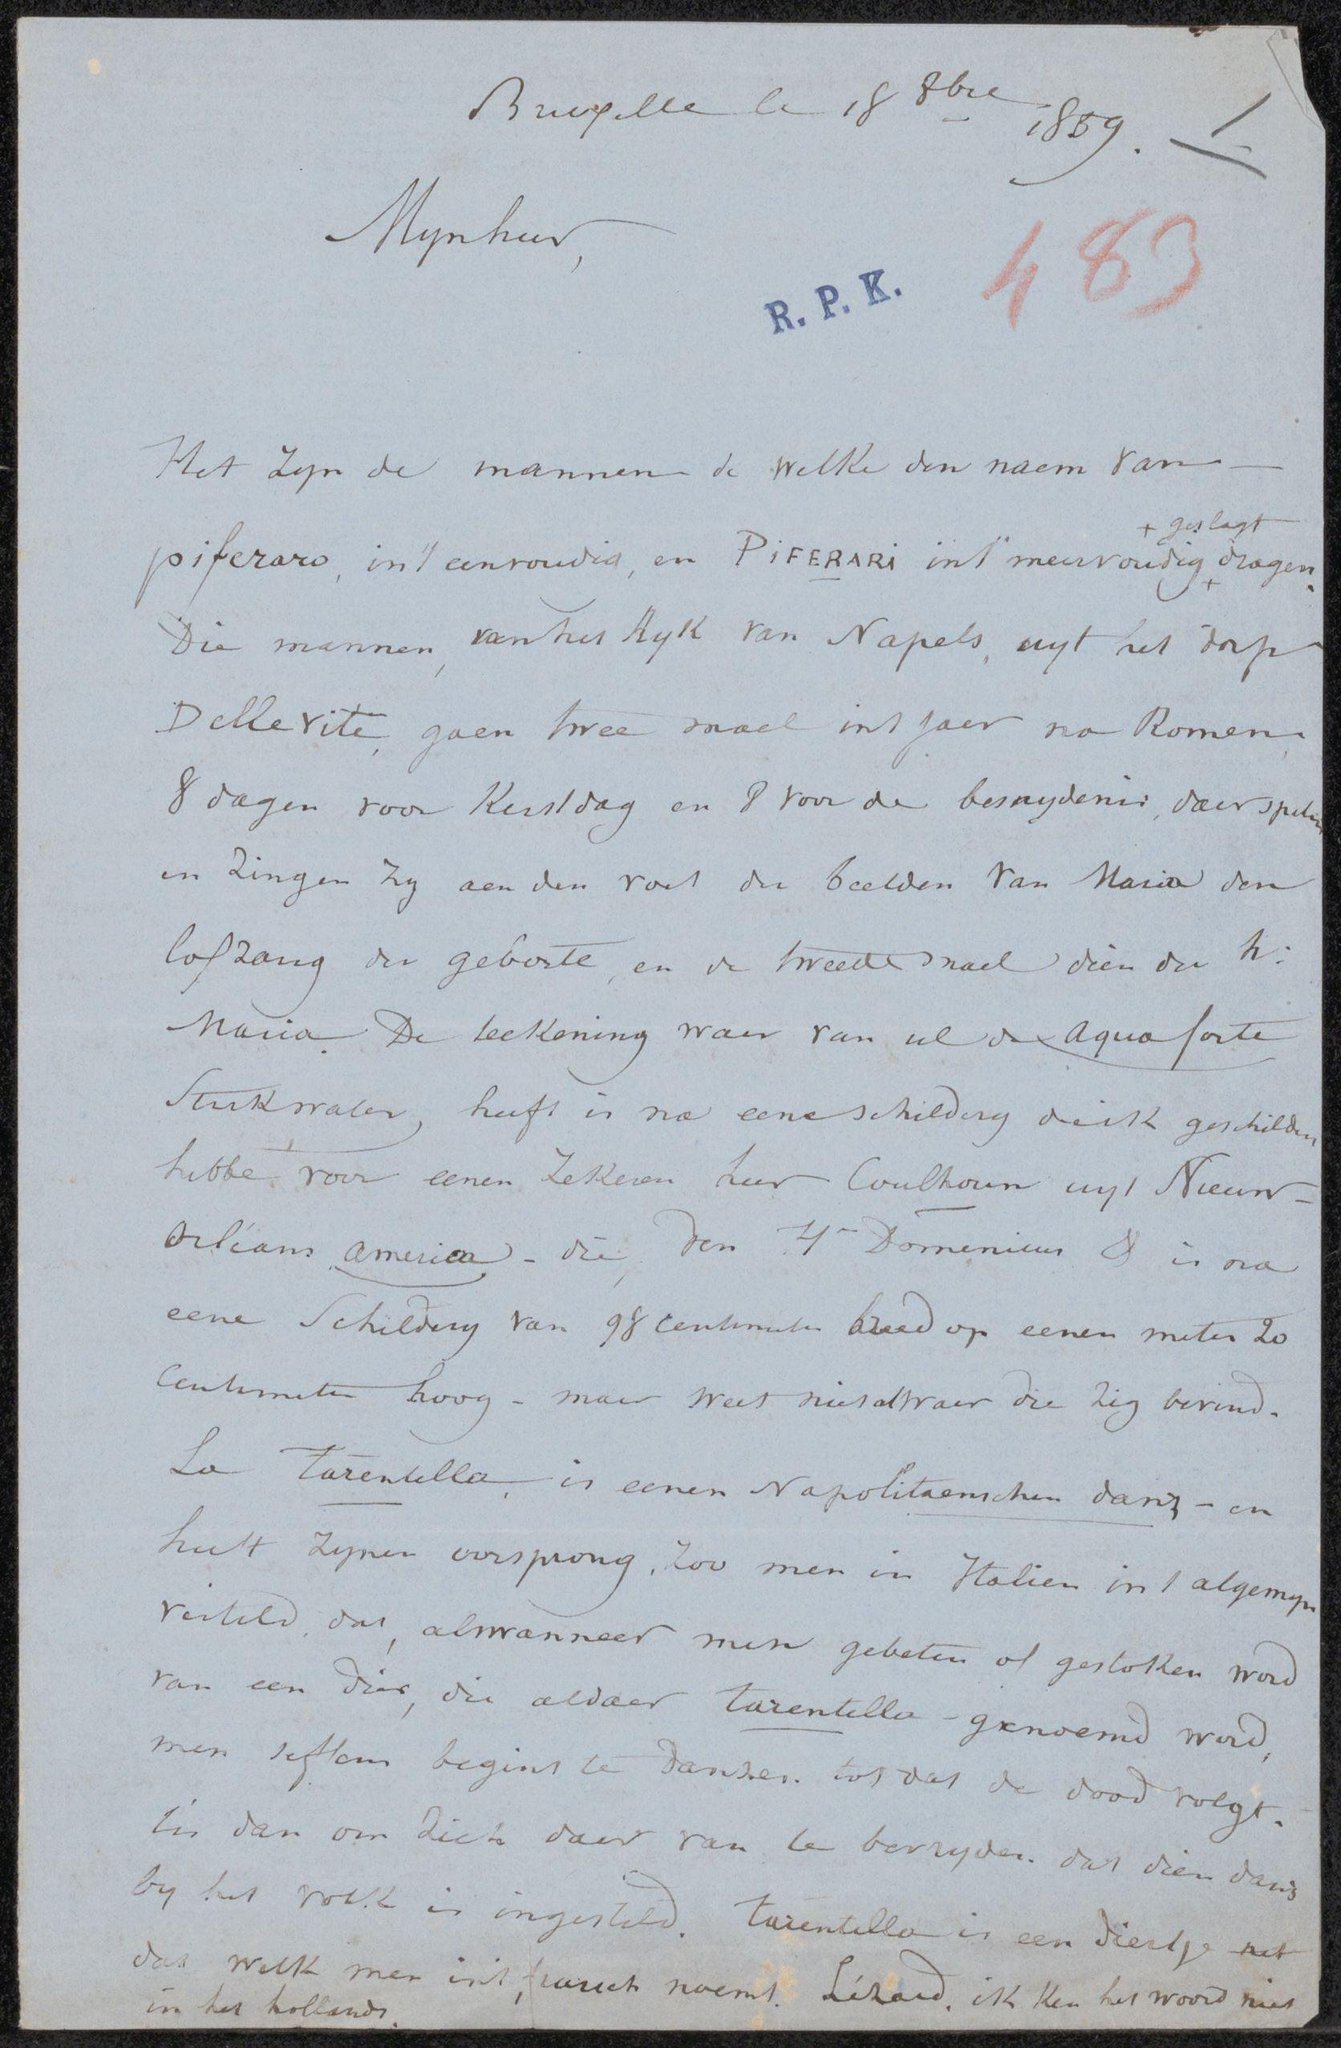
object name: letter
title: Brief aan Christiaan Kramm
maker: joseph meganck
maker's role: print maker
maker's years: 1807-1891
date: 1859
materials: ink, paper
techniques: pen, writing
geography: brussels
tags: brussels, edouard de biefve, painter, joseph paelinck, paris, sculptor, pierre jean david d'angers, utrecht, draughtsman, christiaan kramm, drawing, the graphic arts, education, tuition of the artist (in general), painting (including book-illumination, miniature-painting), workshop, studio of the artist (in general), naples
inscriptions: collector's mark: Lugt 2233